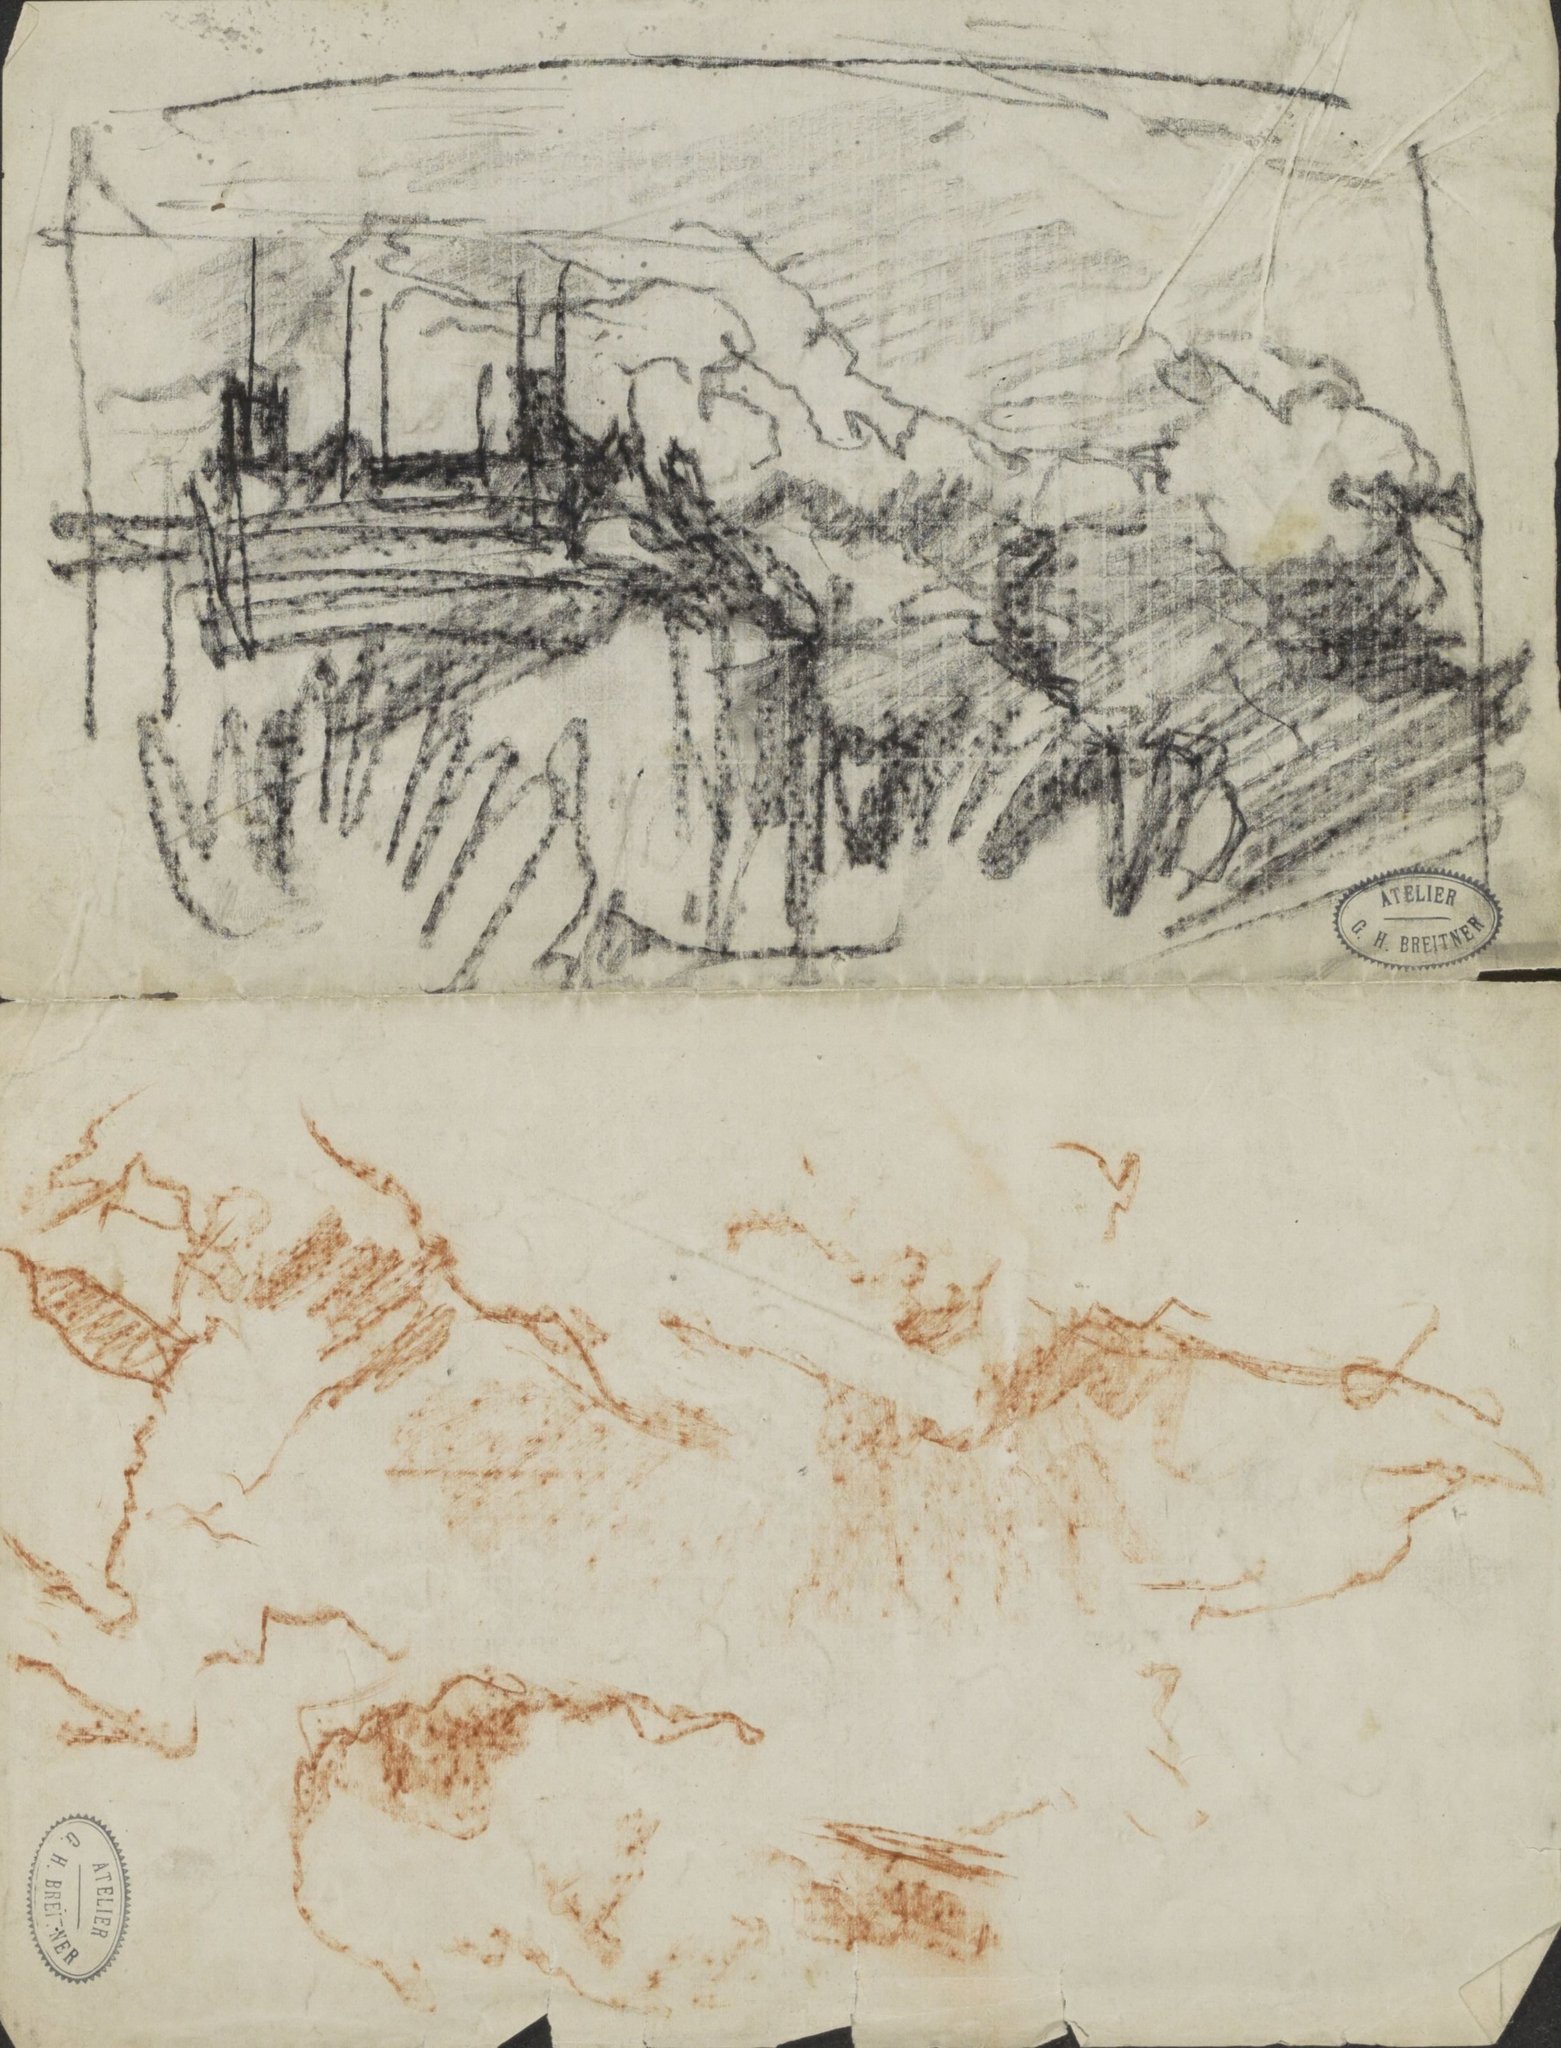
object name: drawing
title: Stadsgezicht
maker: george hendrik breitner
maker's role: draughtsman, painter, print maker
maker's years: 1857-1923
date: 1886-1923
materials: chalk, paper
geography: amsterdam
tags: city-view, and landscape with man-made constructions, shrubs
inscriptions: collector's mark: Lugt 2228, workshop stamp: Lugt 291d